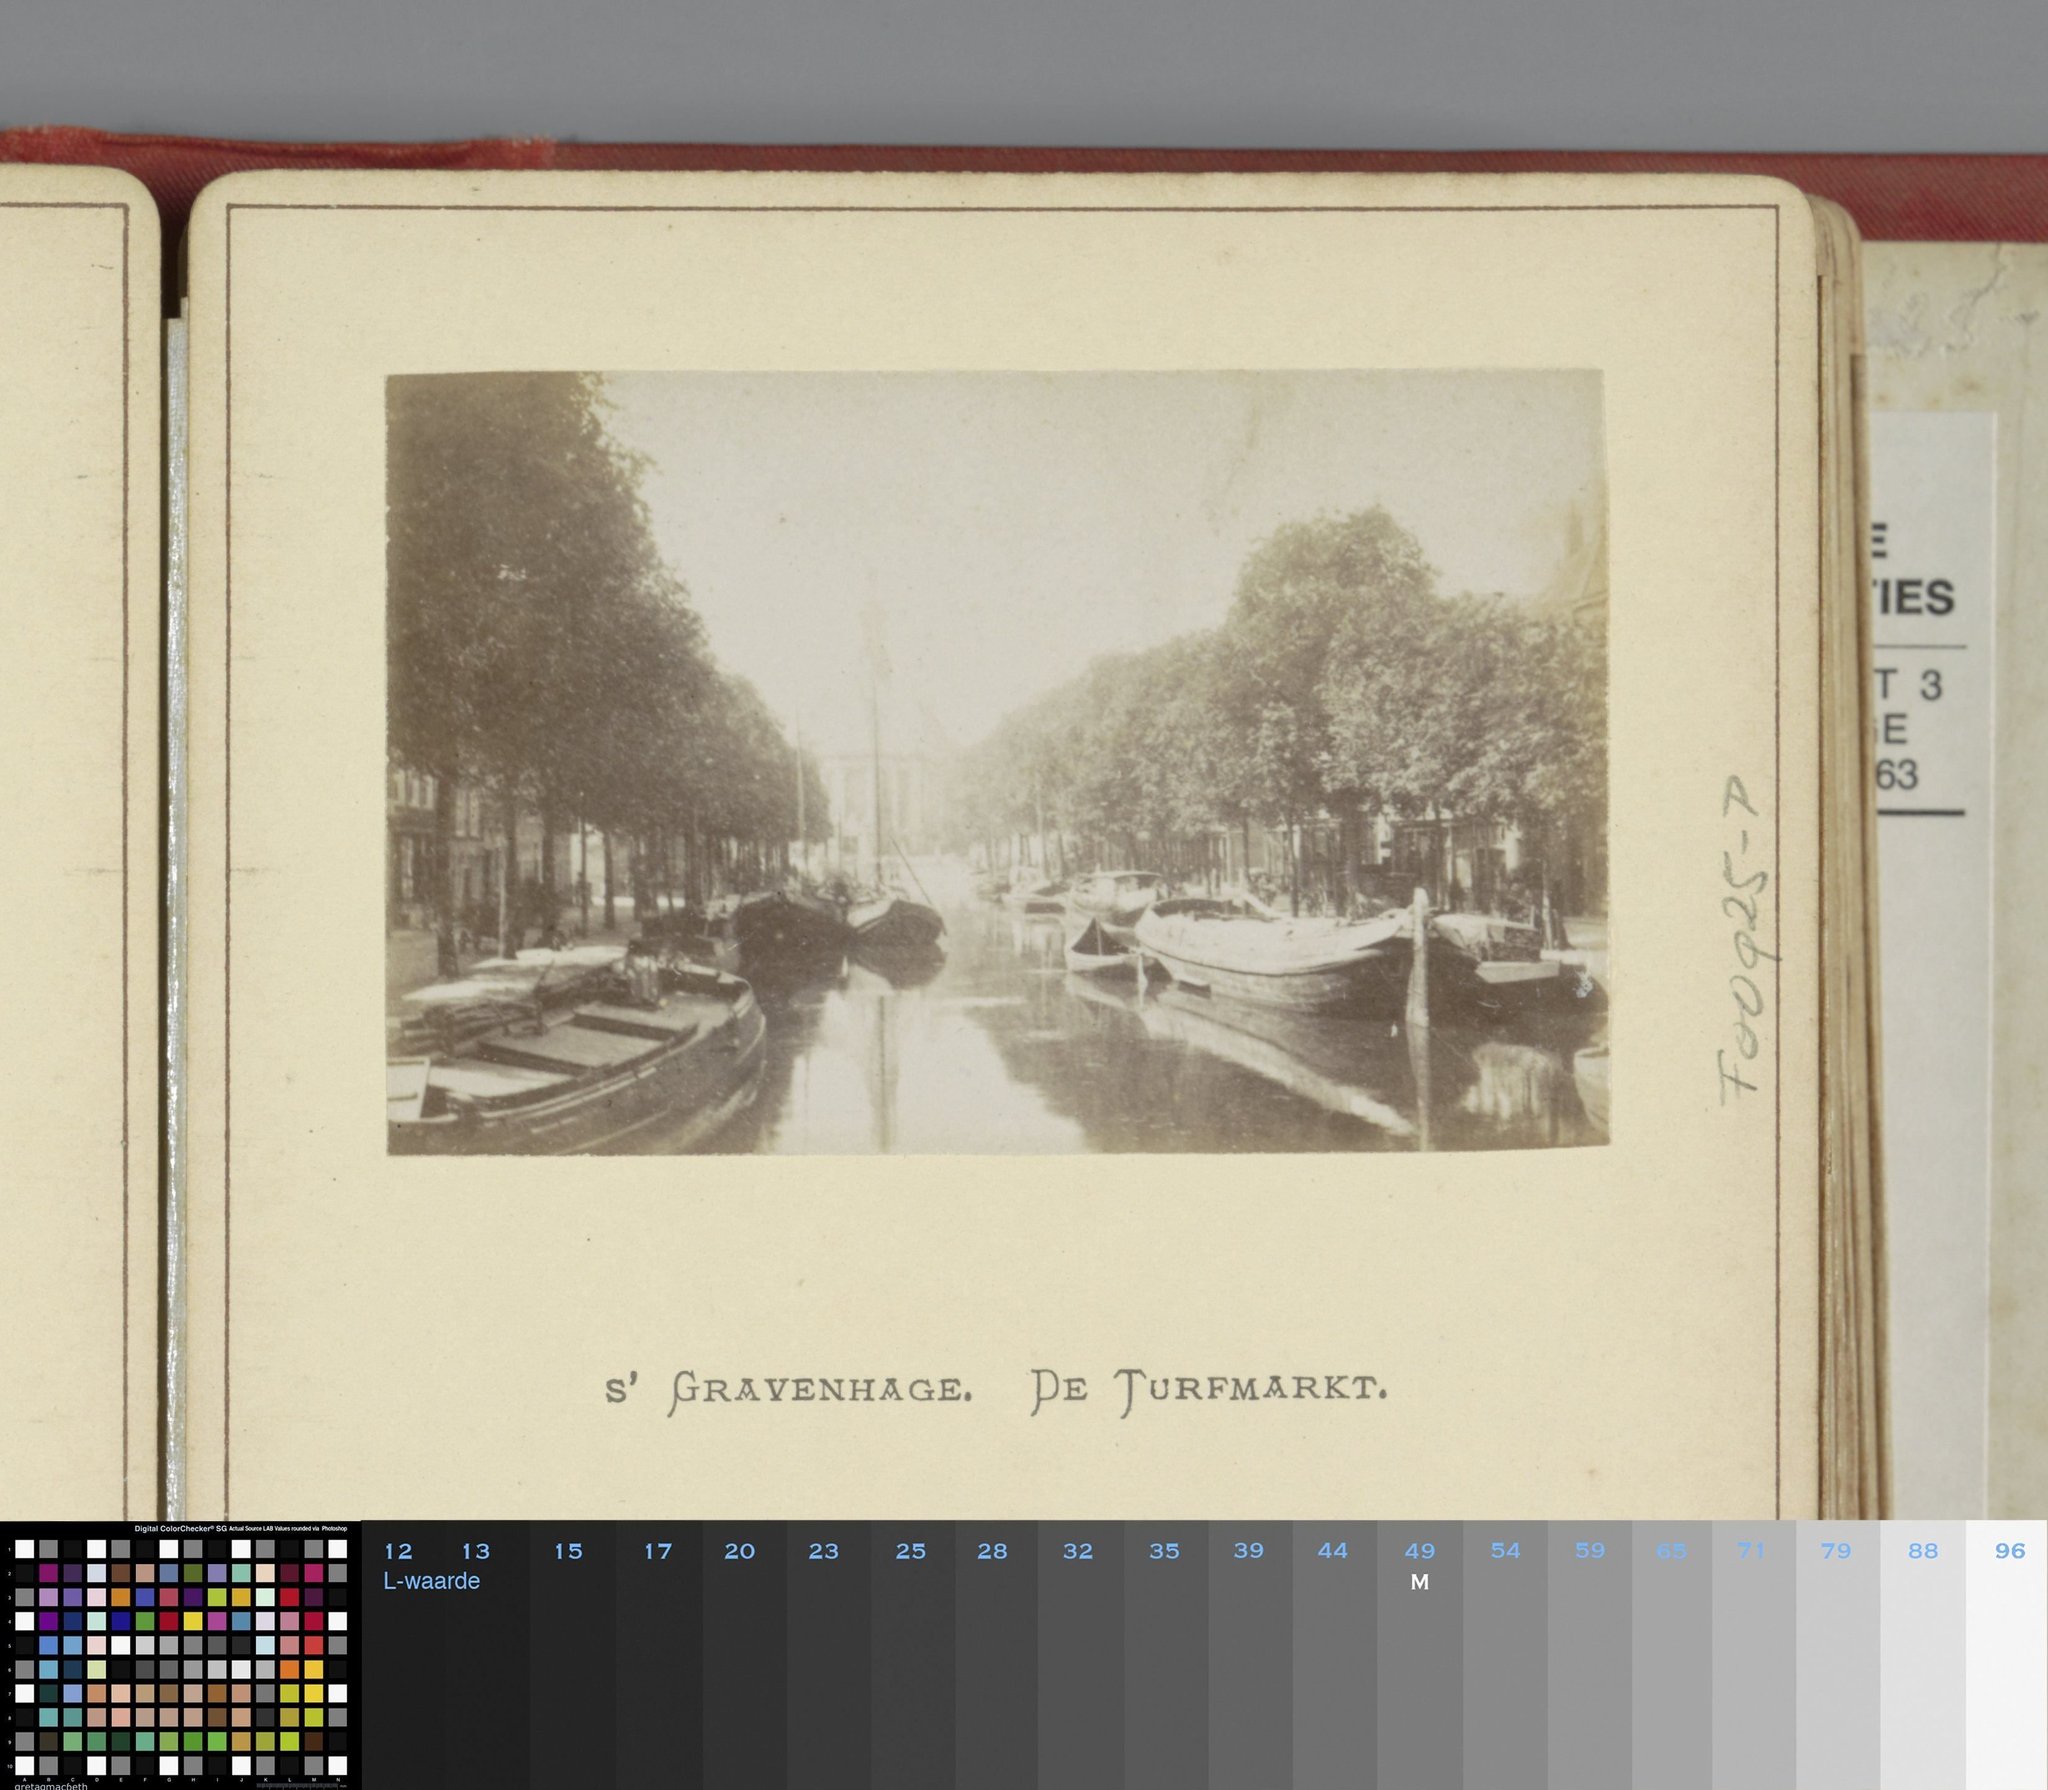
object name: photograph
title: s' Gravenhage. De Turfmarkt.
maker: andries jager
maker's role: publisher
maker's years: 1825-1905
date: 1860-1900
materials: cardboard, photographic support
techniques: albumen print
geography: the hague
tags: canal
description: Onderdeel van Fotoalbum met opnames van steden in Noord- en Zuid-Holland en Utrecht.